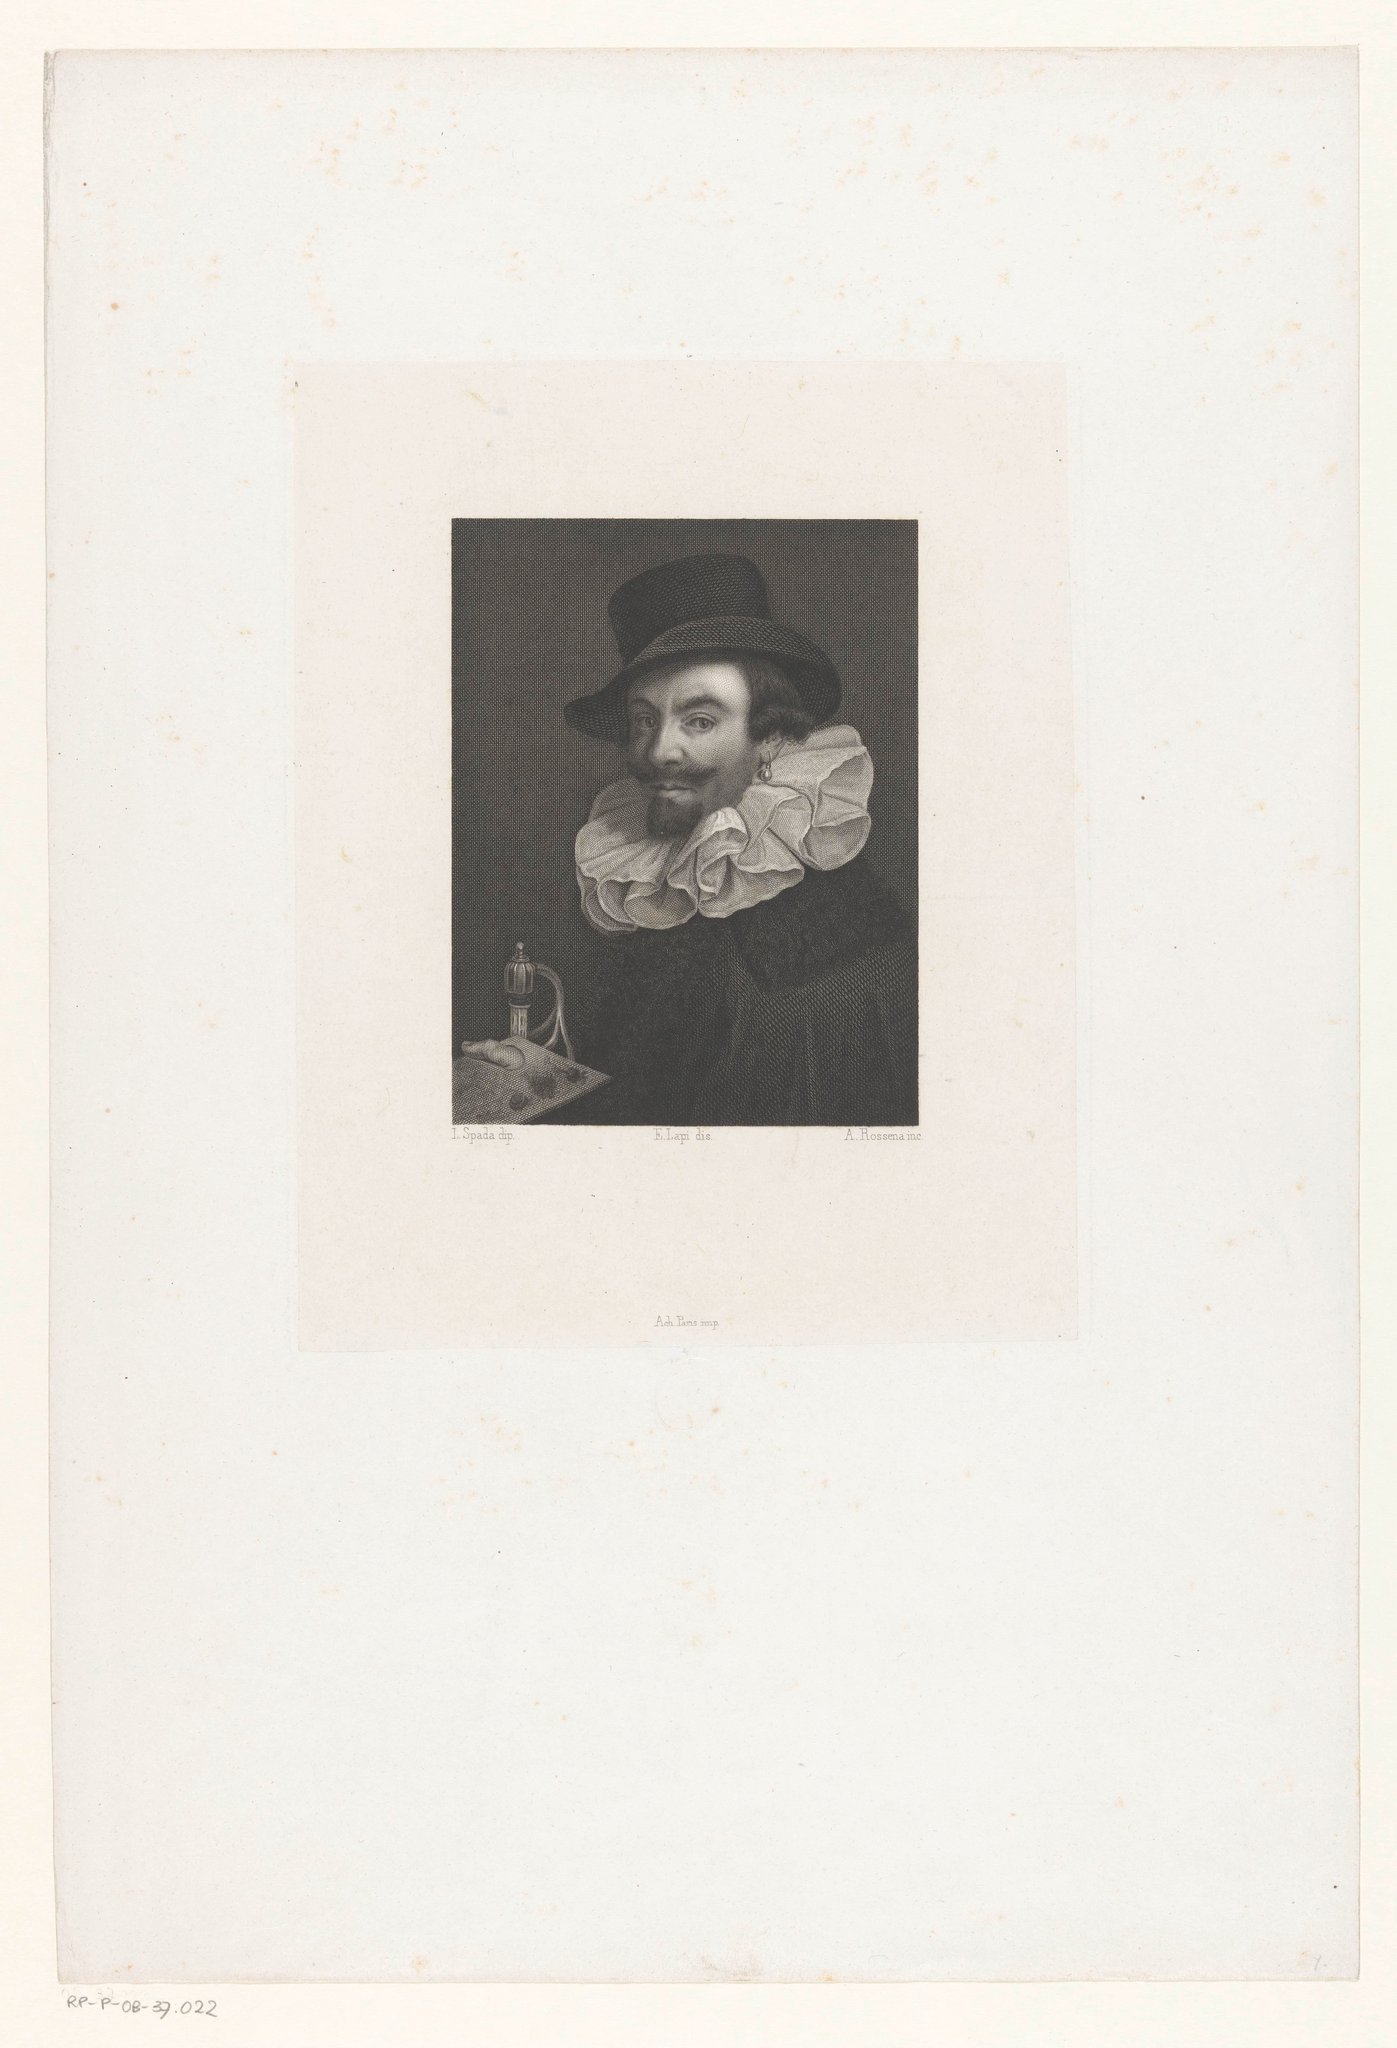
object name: print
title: Portret van schilder Lionello Spada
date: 1800-1899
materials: paper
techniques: engraving, etching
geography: italy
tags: painter, draughtsman, lionello spada, historical persons, portrait, self-portrait of painter, portrait, self-portrait of artist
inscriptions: collector's mark: ‘Onduidelijk.’, collector's mark: Lugt 2228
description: Naar een geschilderd zelfportret door Lionello Spada in de Vasari Corridor te Florence.